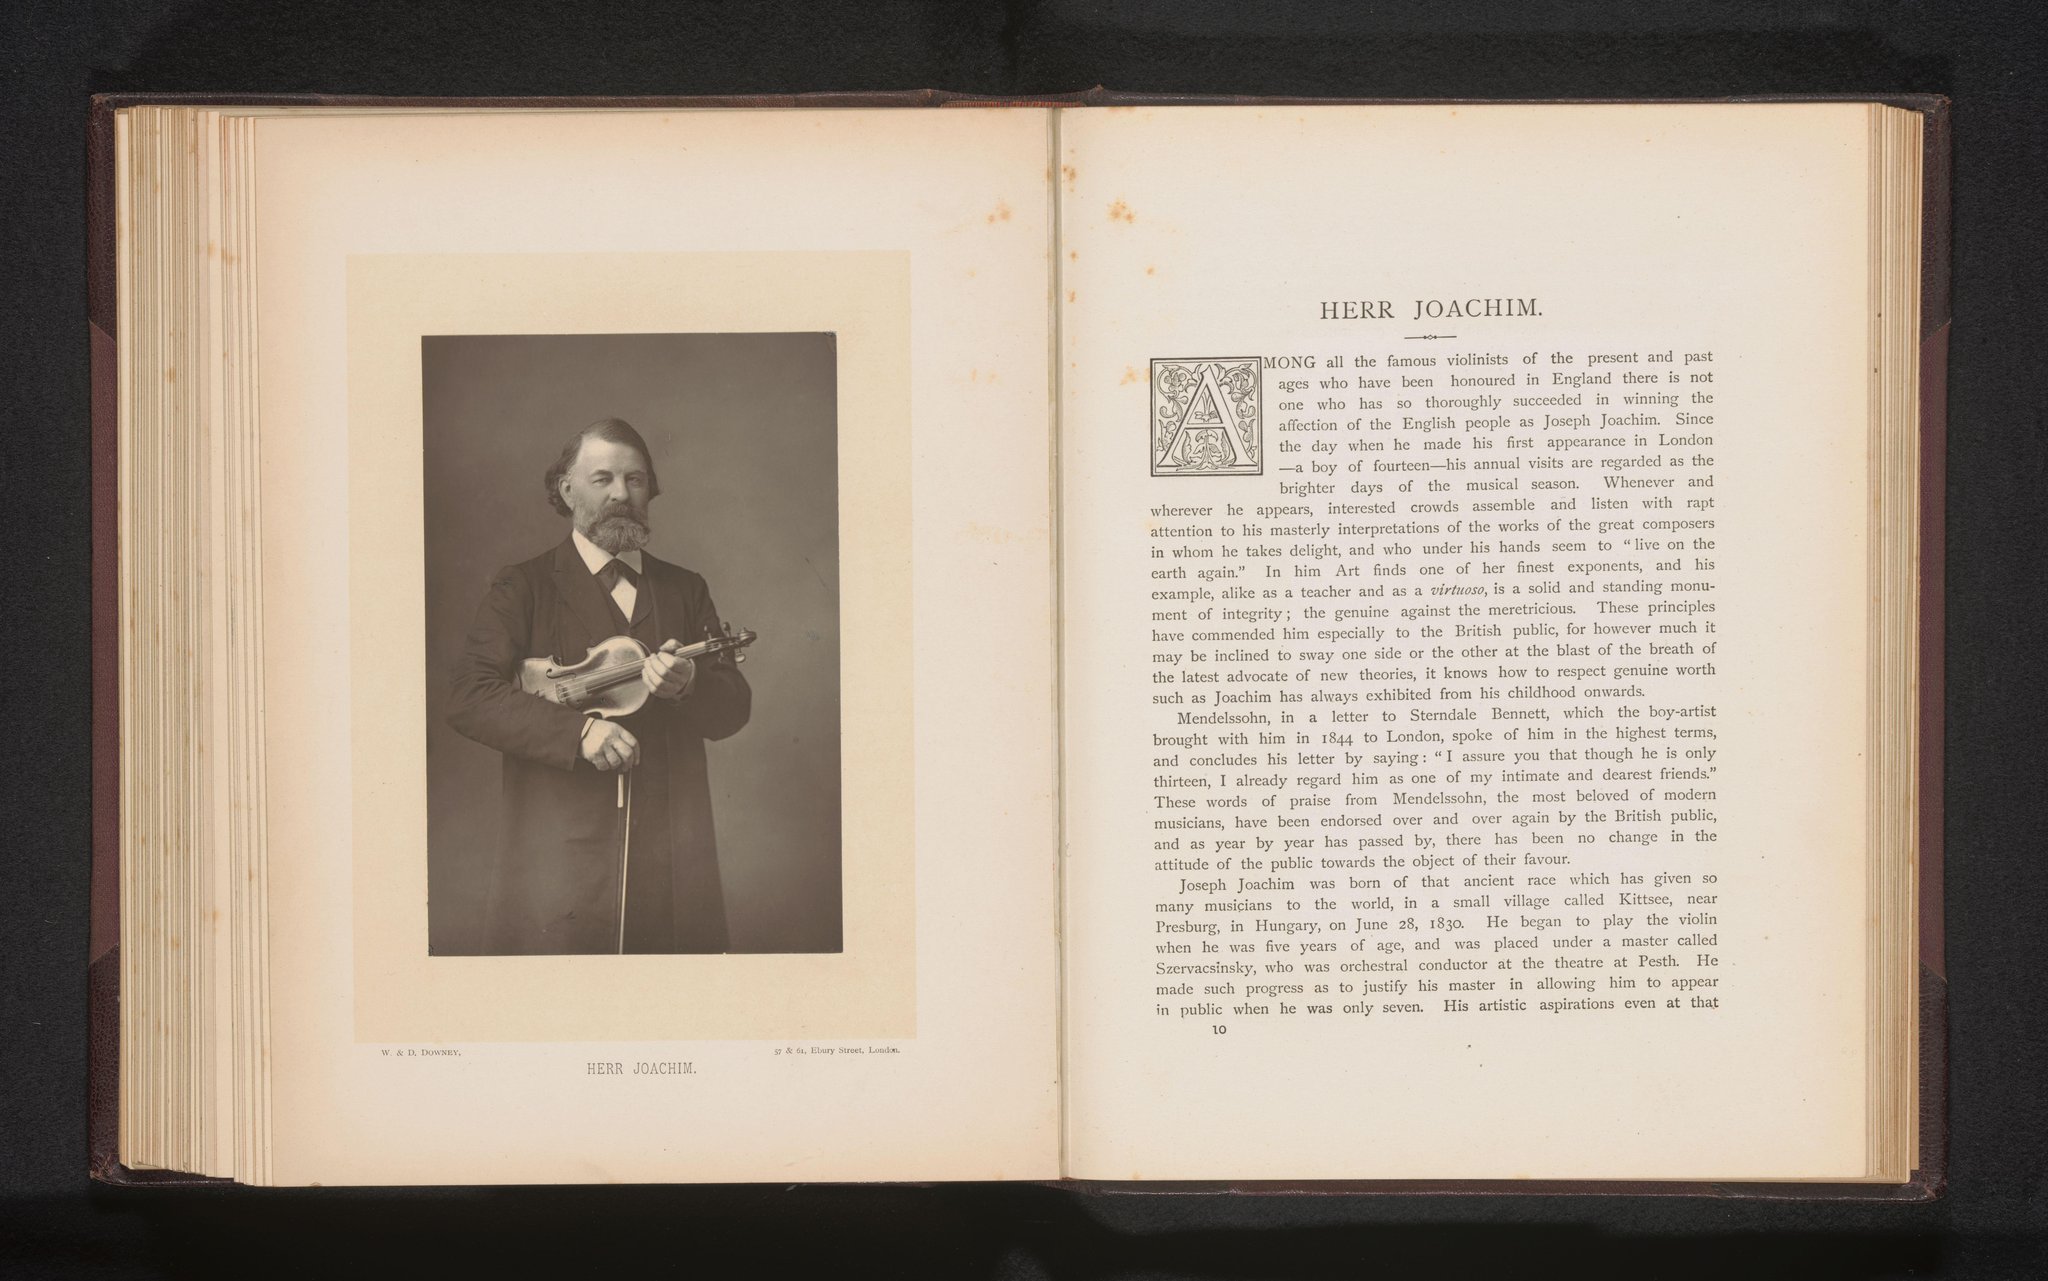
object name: page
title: Herr Joachim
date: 1885-1890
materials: paper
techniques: carbon print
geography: london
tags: musician, historical persons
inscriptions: address: ‘57 & 61, Ebury Street, London.’